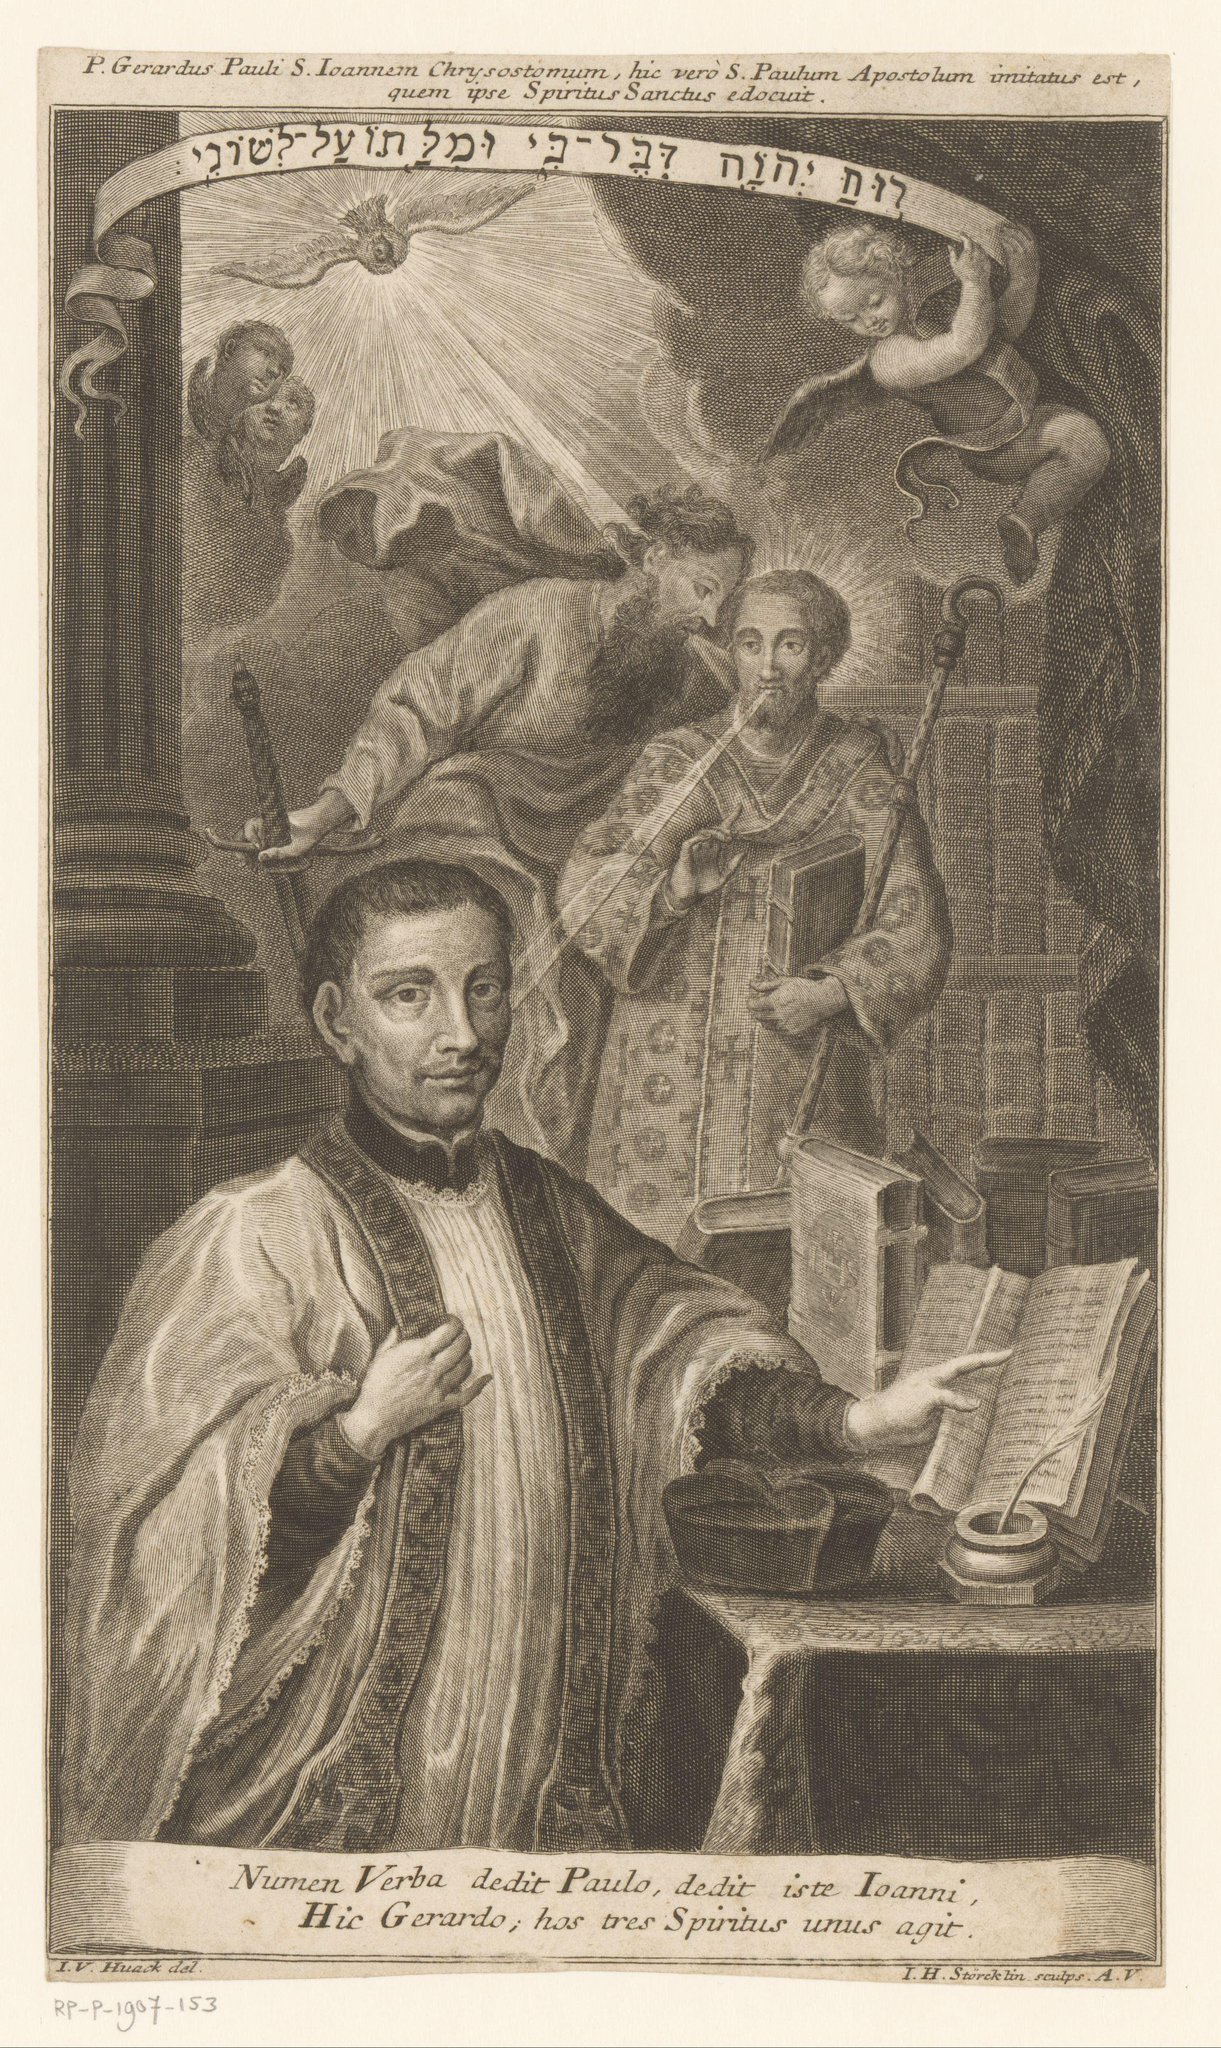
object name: print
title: Portret van Gerhard Pauli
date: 1697-1737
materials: paper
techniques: engraving, etching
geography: augsburg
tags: bookshelves, historical persons, book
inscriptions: collector's mark: Lugt 2228